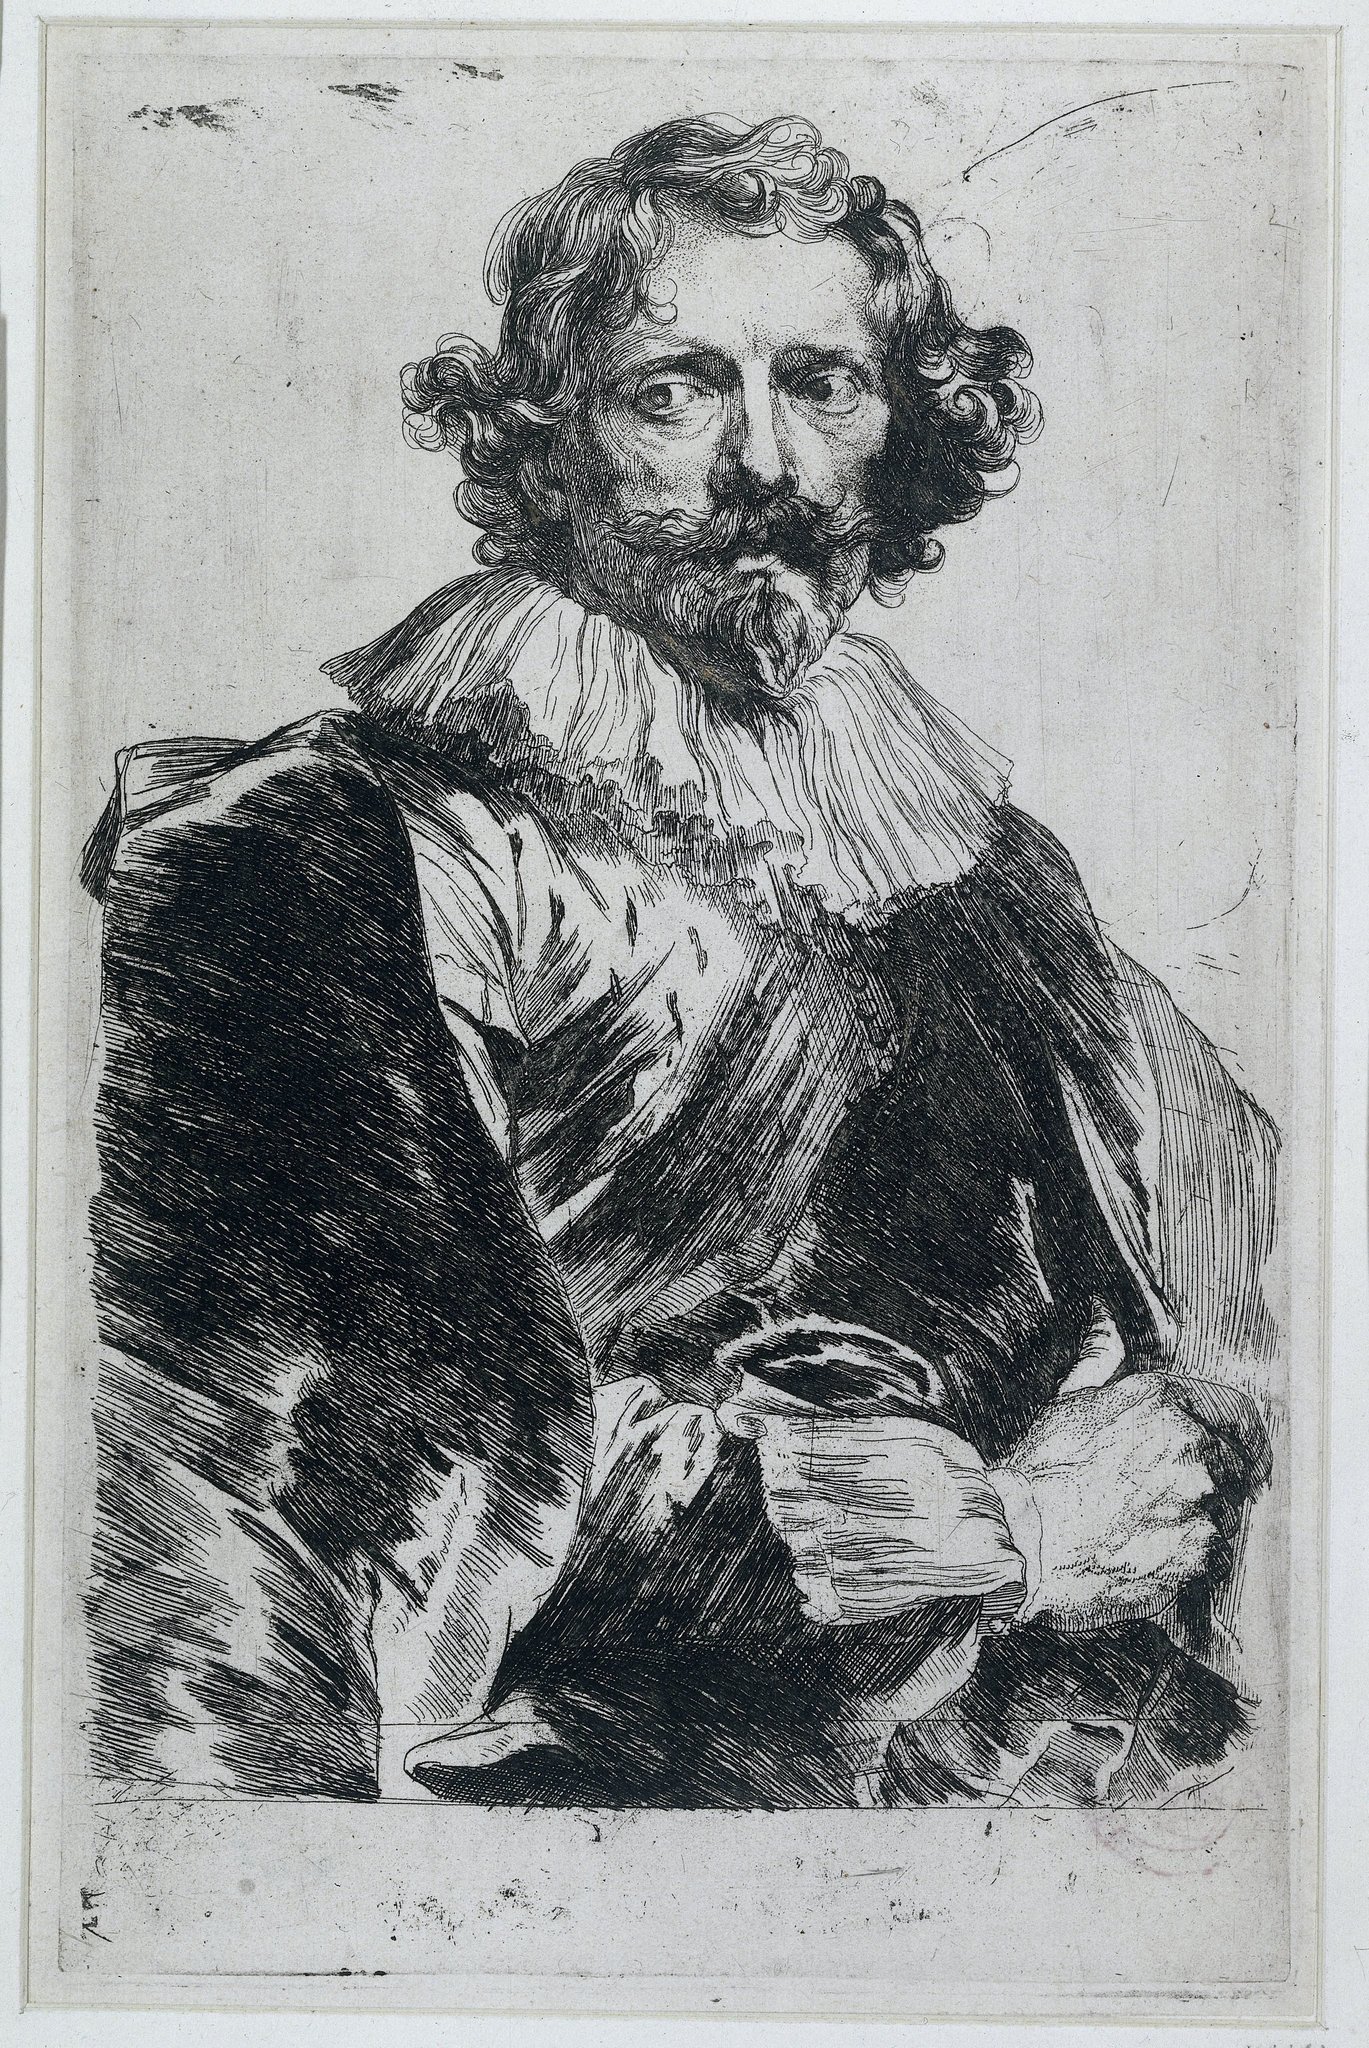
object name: print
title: Iconographie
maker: anthony van dyck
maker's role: draughtsman, painter, print maker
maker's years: 1599-1641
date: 1630-1632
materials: paper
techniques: etching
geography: low countries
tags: print maker, lucas vorsterman (i), portrait, self-portrait of graphic artist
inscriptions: collector's mark: Lugt 240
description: De schilder en graveur Lucas Vorsterman I (1595-1675 ): kniestuk, naar rechts. Vorsterman was al op 12-jarige leeftijd werkzaam als graveur. In 1617 of 1618 kwam hij als leerling in het atelier van de Antwerpse kunstenaar Peter Paul Rubens, waar hij in 1620 de meestertitel kreeg. Rubens liet Vorsterman gravures maken naar zijn schilderijen. De relatie verslechterde en Vorsterman vertrok in 1624 naar Engeland. Na zijn terugkeer omstreeks 1630 werkte hij voor onder andere Antoon van Dyck.